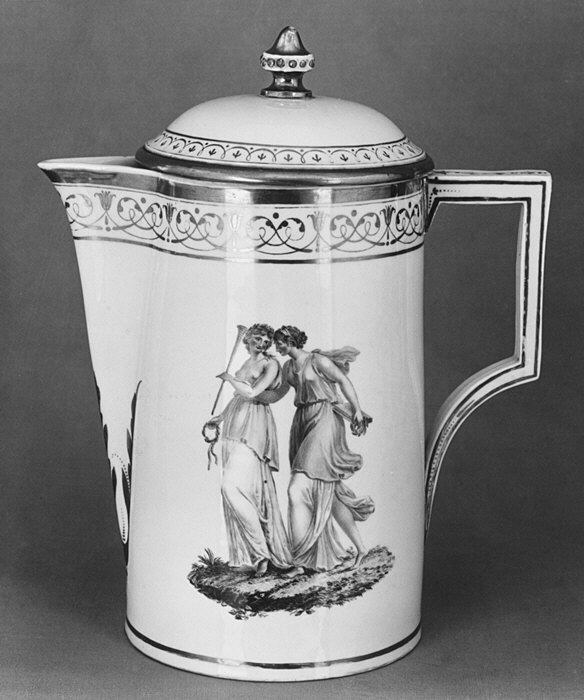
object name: coffeepot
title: Coffeepot (part of a coffee service)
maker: nymphenburg porcelain manufactory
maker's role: manufactory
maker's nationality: german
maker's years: 1747-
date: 1801-1833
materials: hard paste porcelain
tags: women